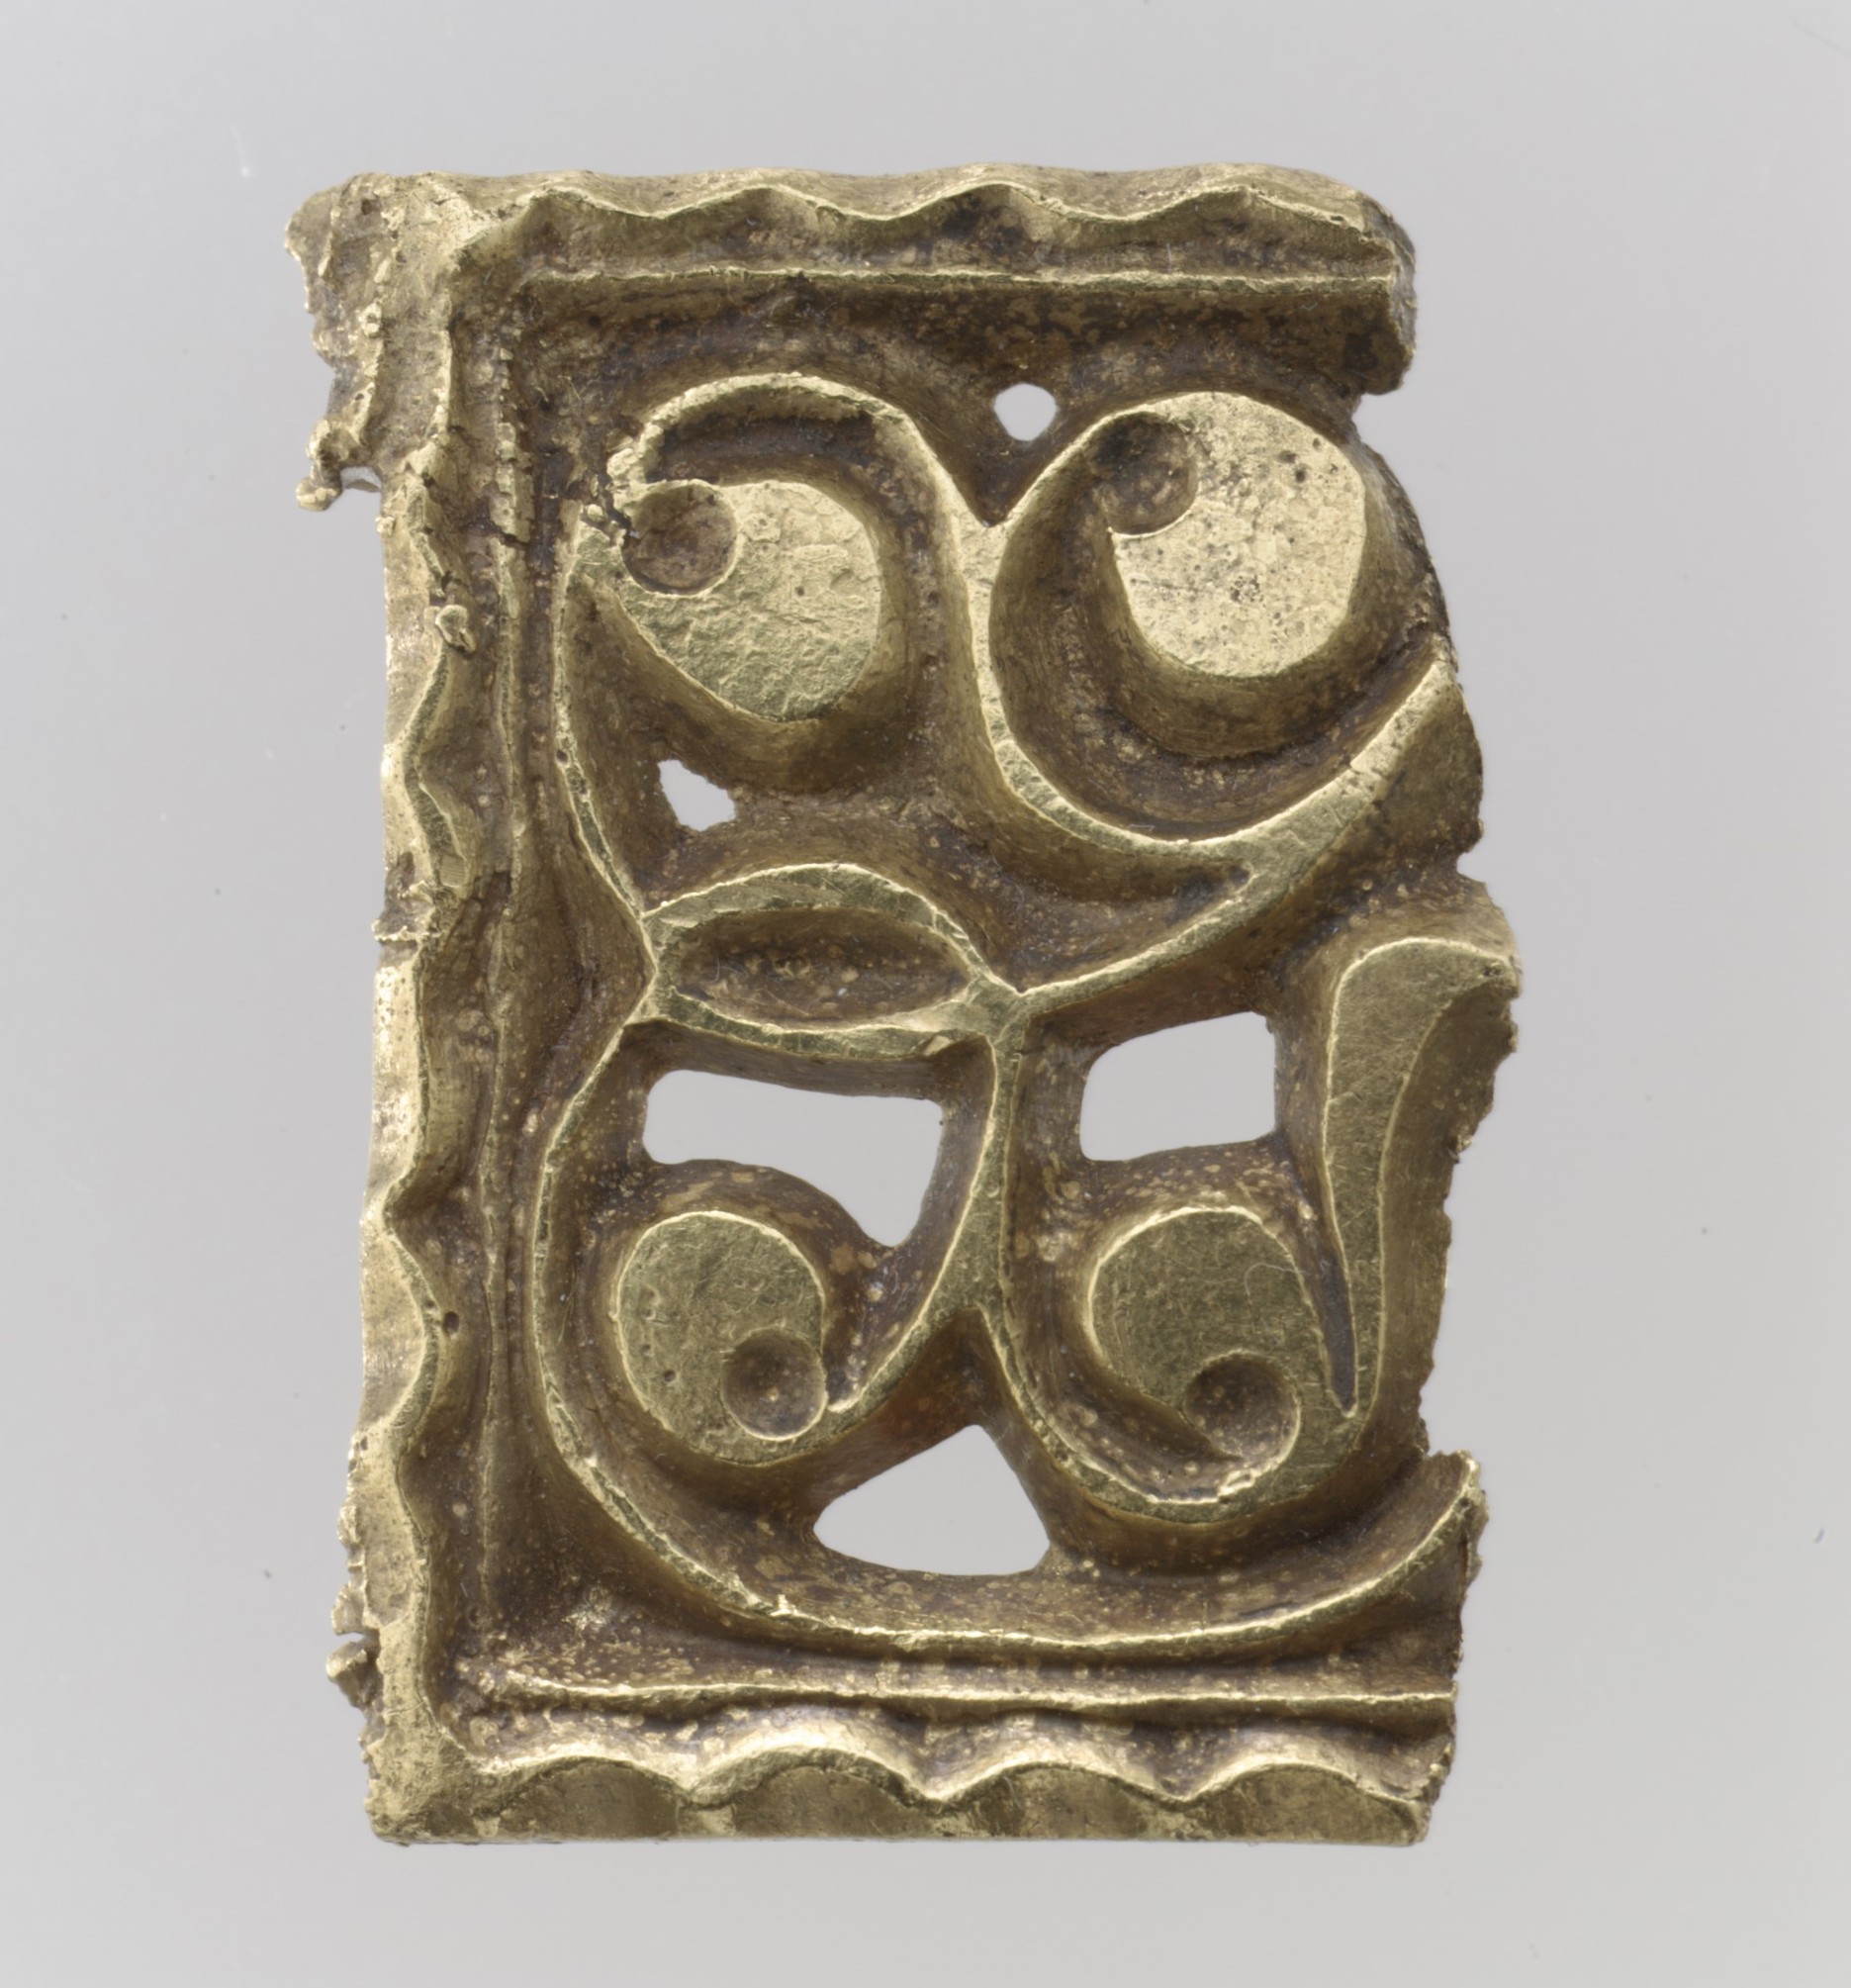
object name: belt counter plate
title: Fragment of a Gold Attachment Plate for a Buckle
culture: avar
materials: gold